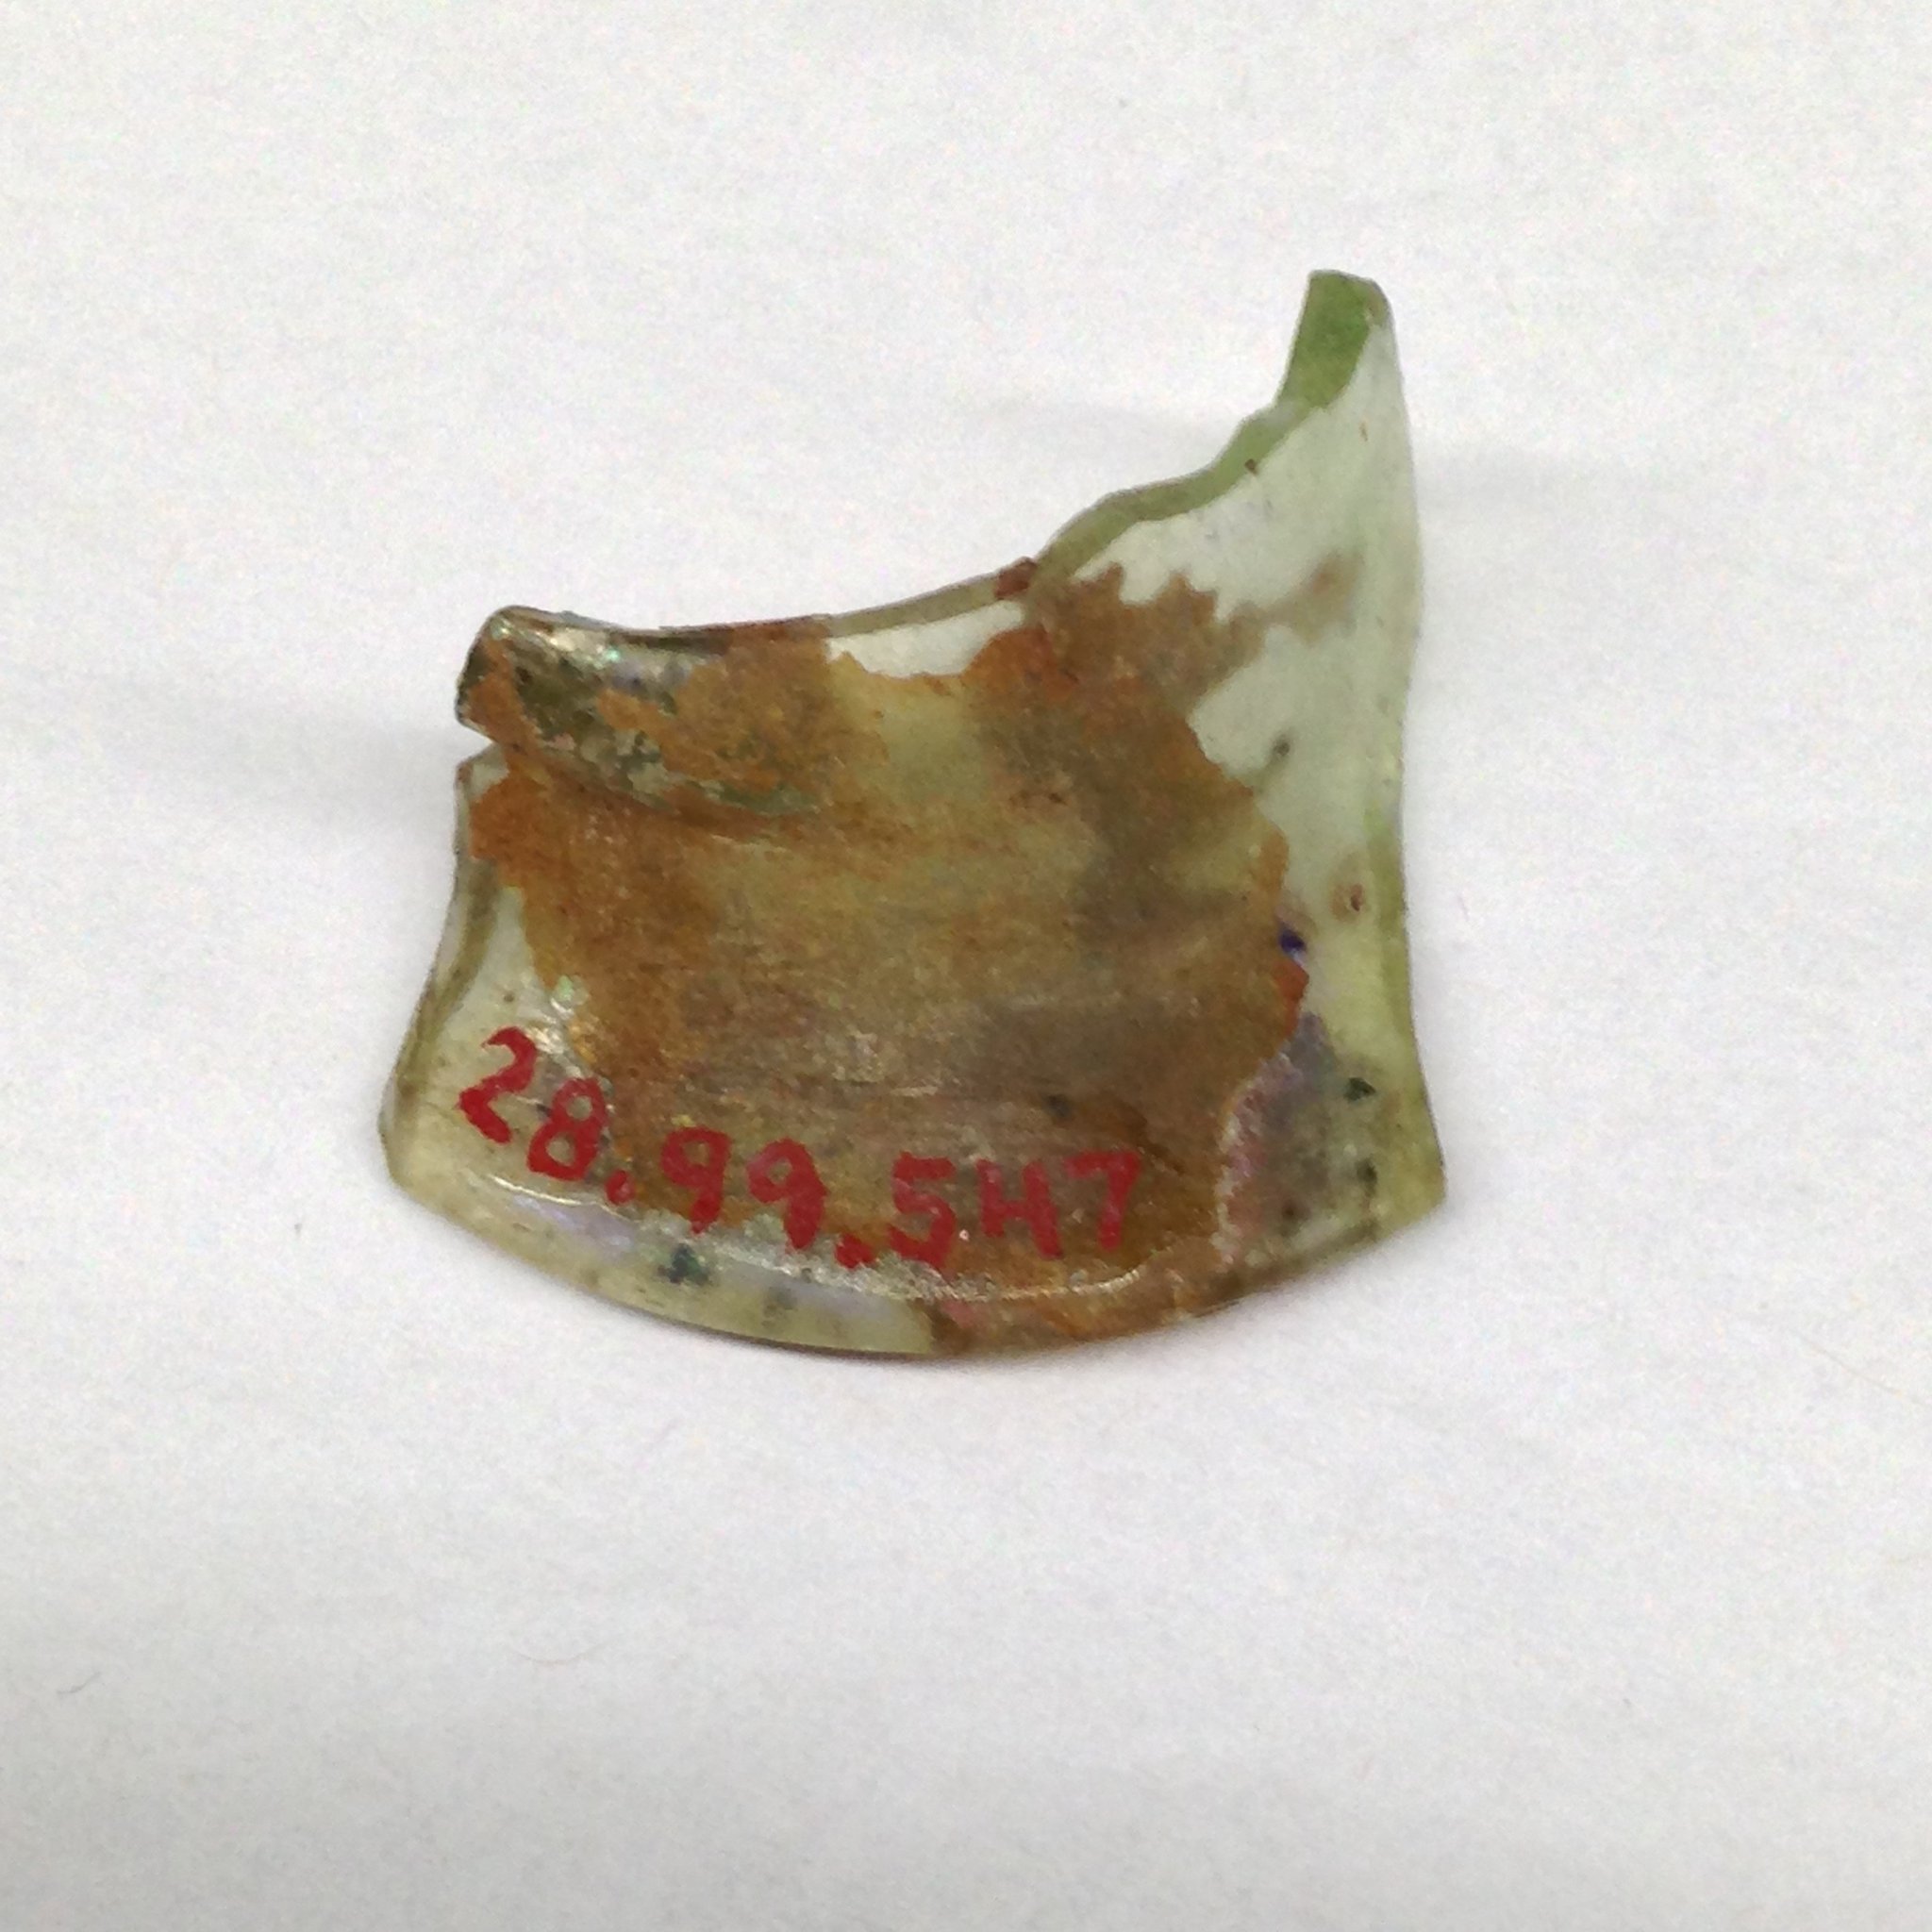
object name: fragment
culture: european or middle eastern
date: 1150-1250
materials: ceramic, glass